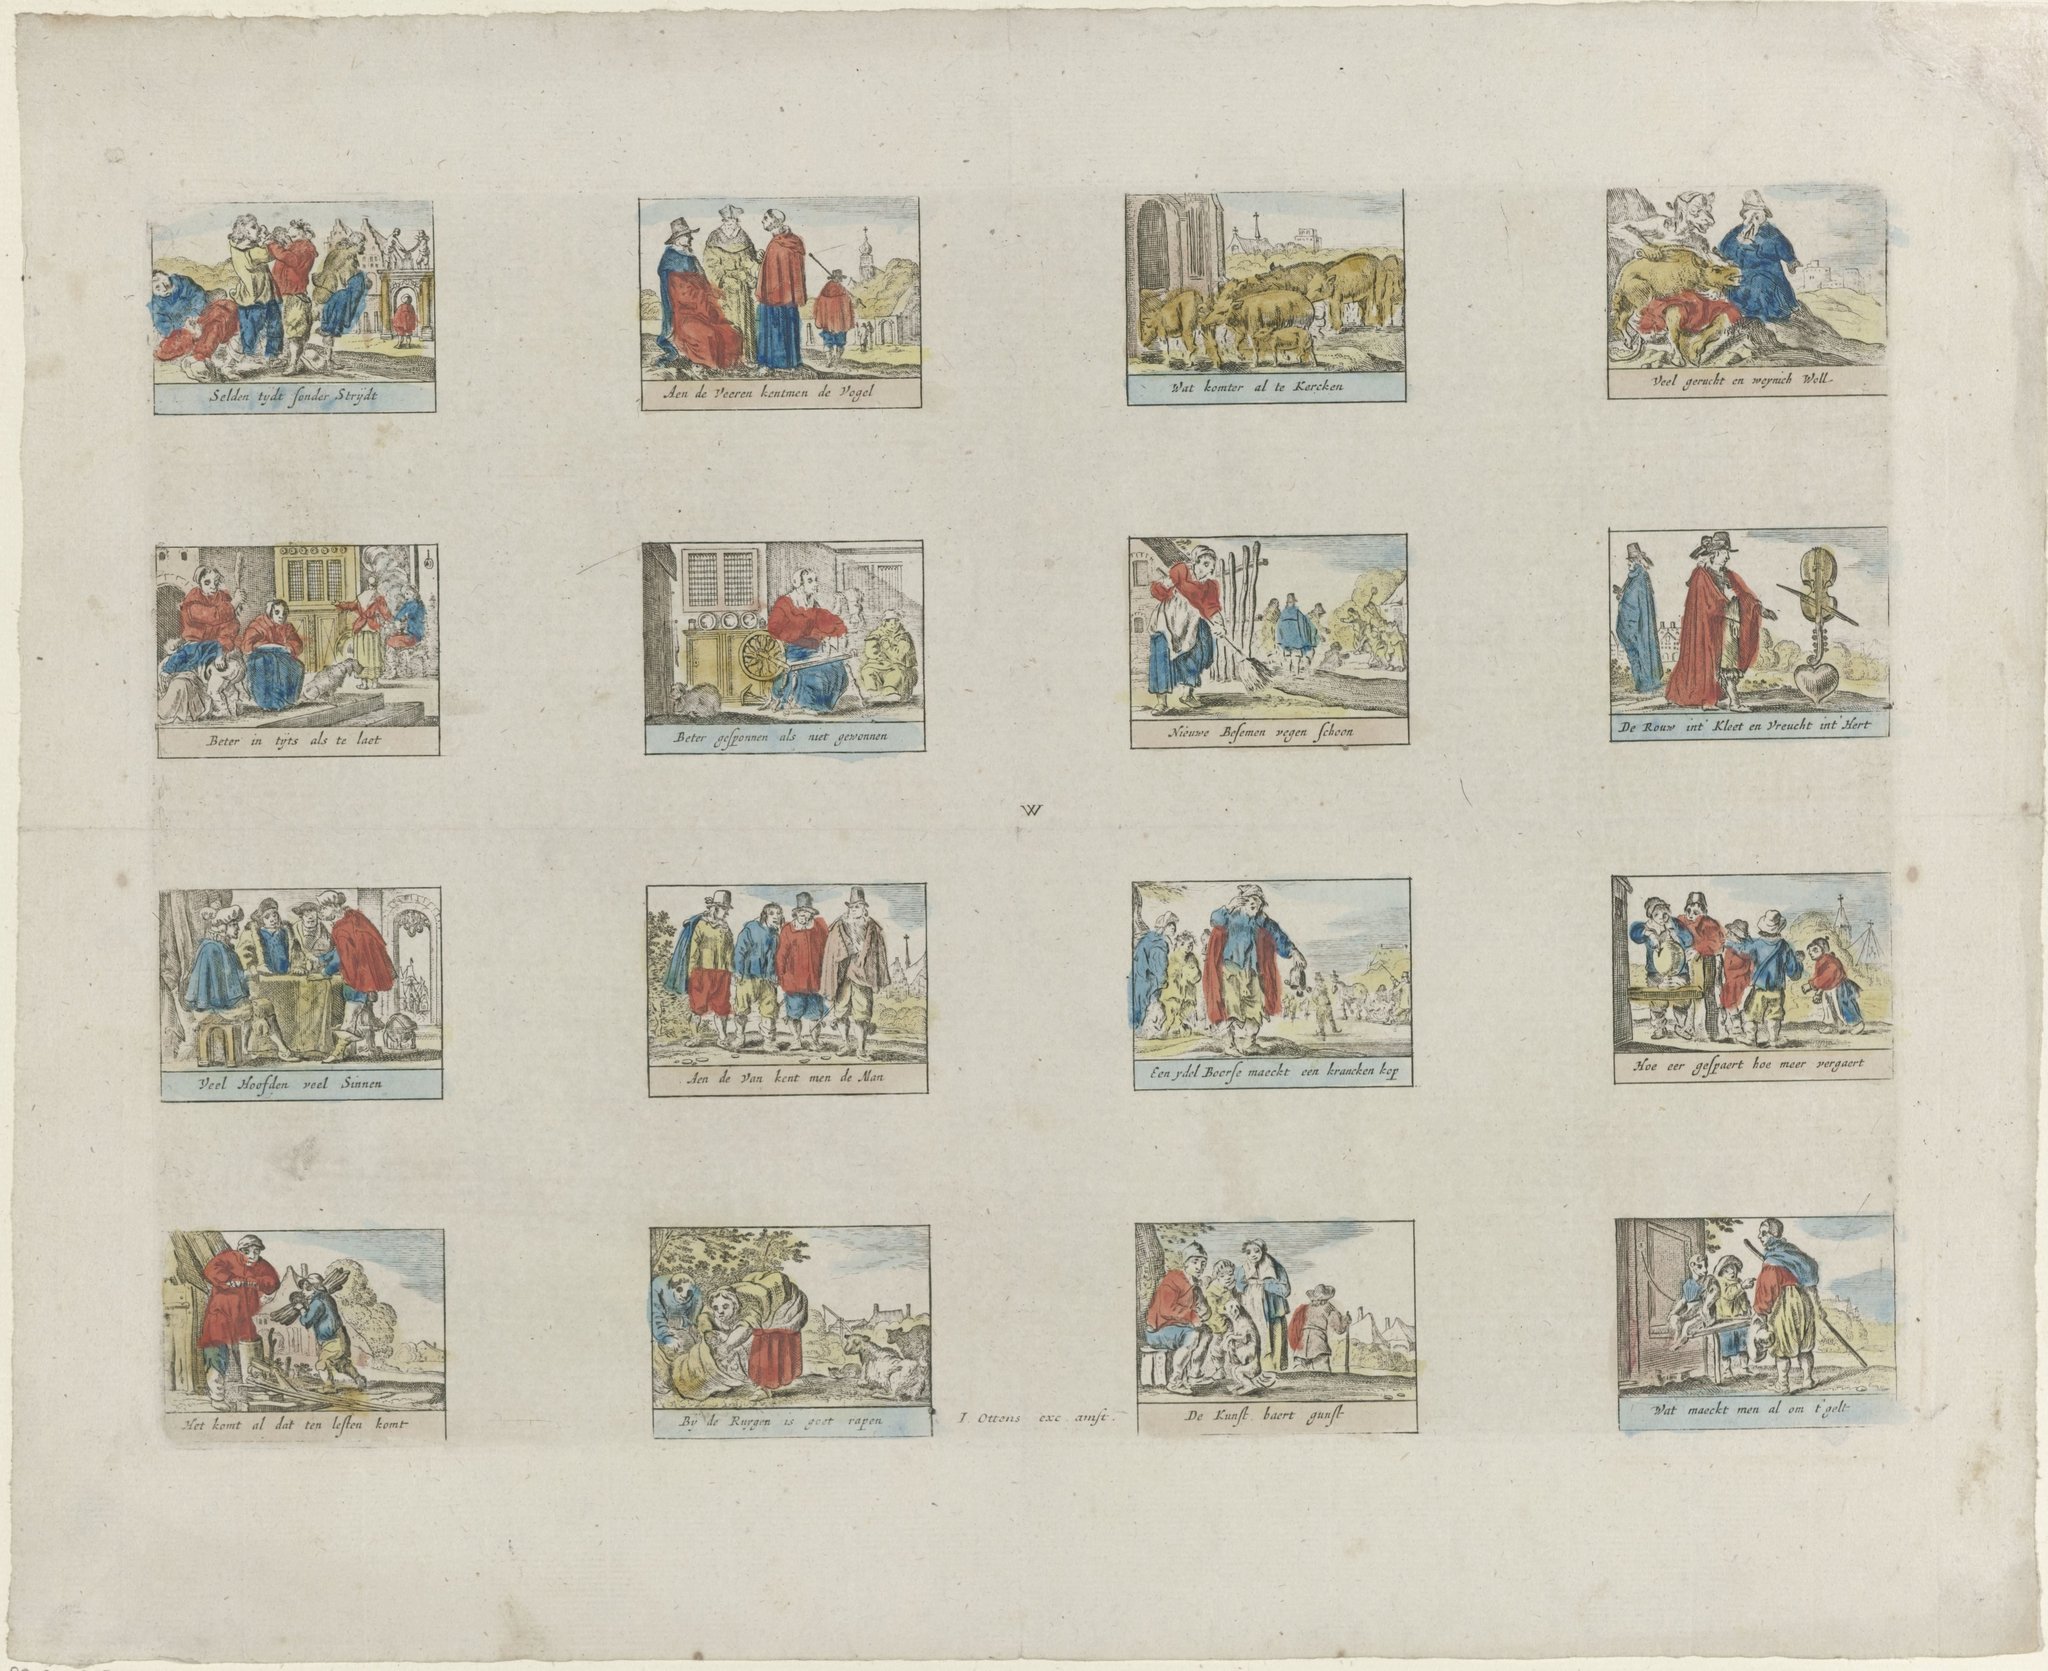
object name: print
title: Uitdrukkingen en gezegden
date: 1689-1720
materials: paper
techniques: colour, engraving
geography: amsterdam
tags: proverbs, sayings, etc.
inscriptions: collector's mark: Lugt 2760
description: Blad met 16 verbeeldingen van spreekwoorden. Onder elke afbeelding een onderschrift. Gemerkt midden: W.